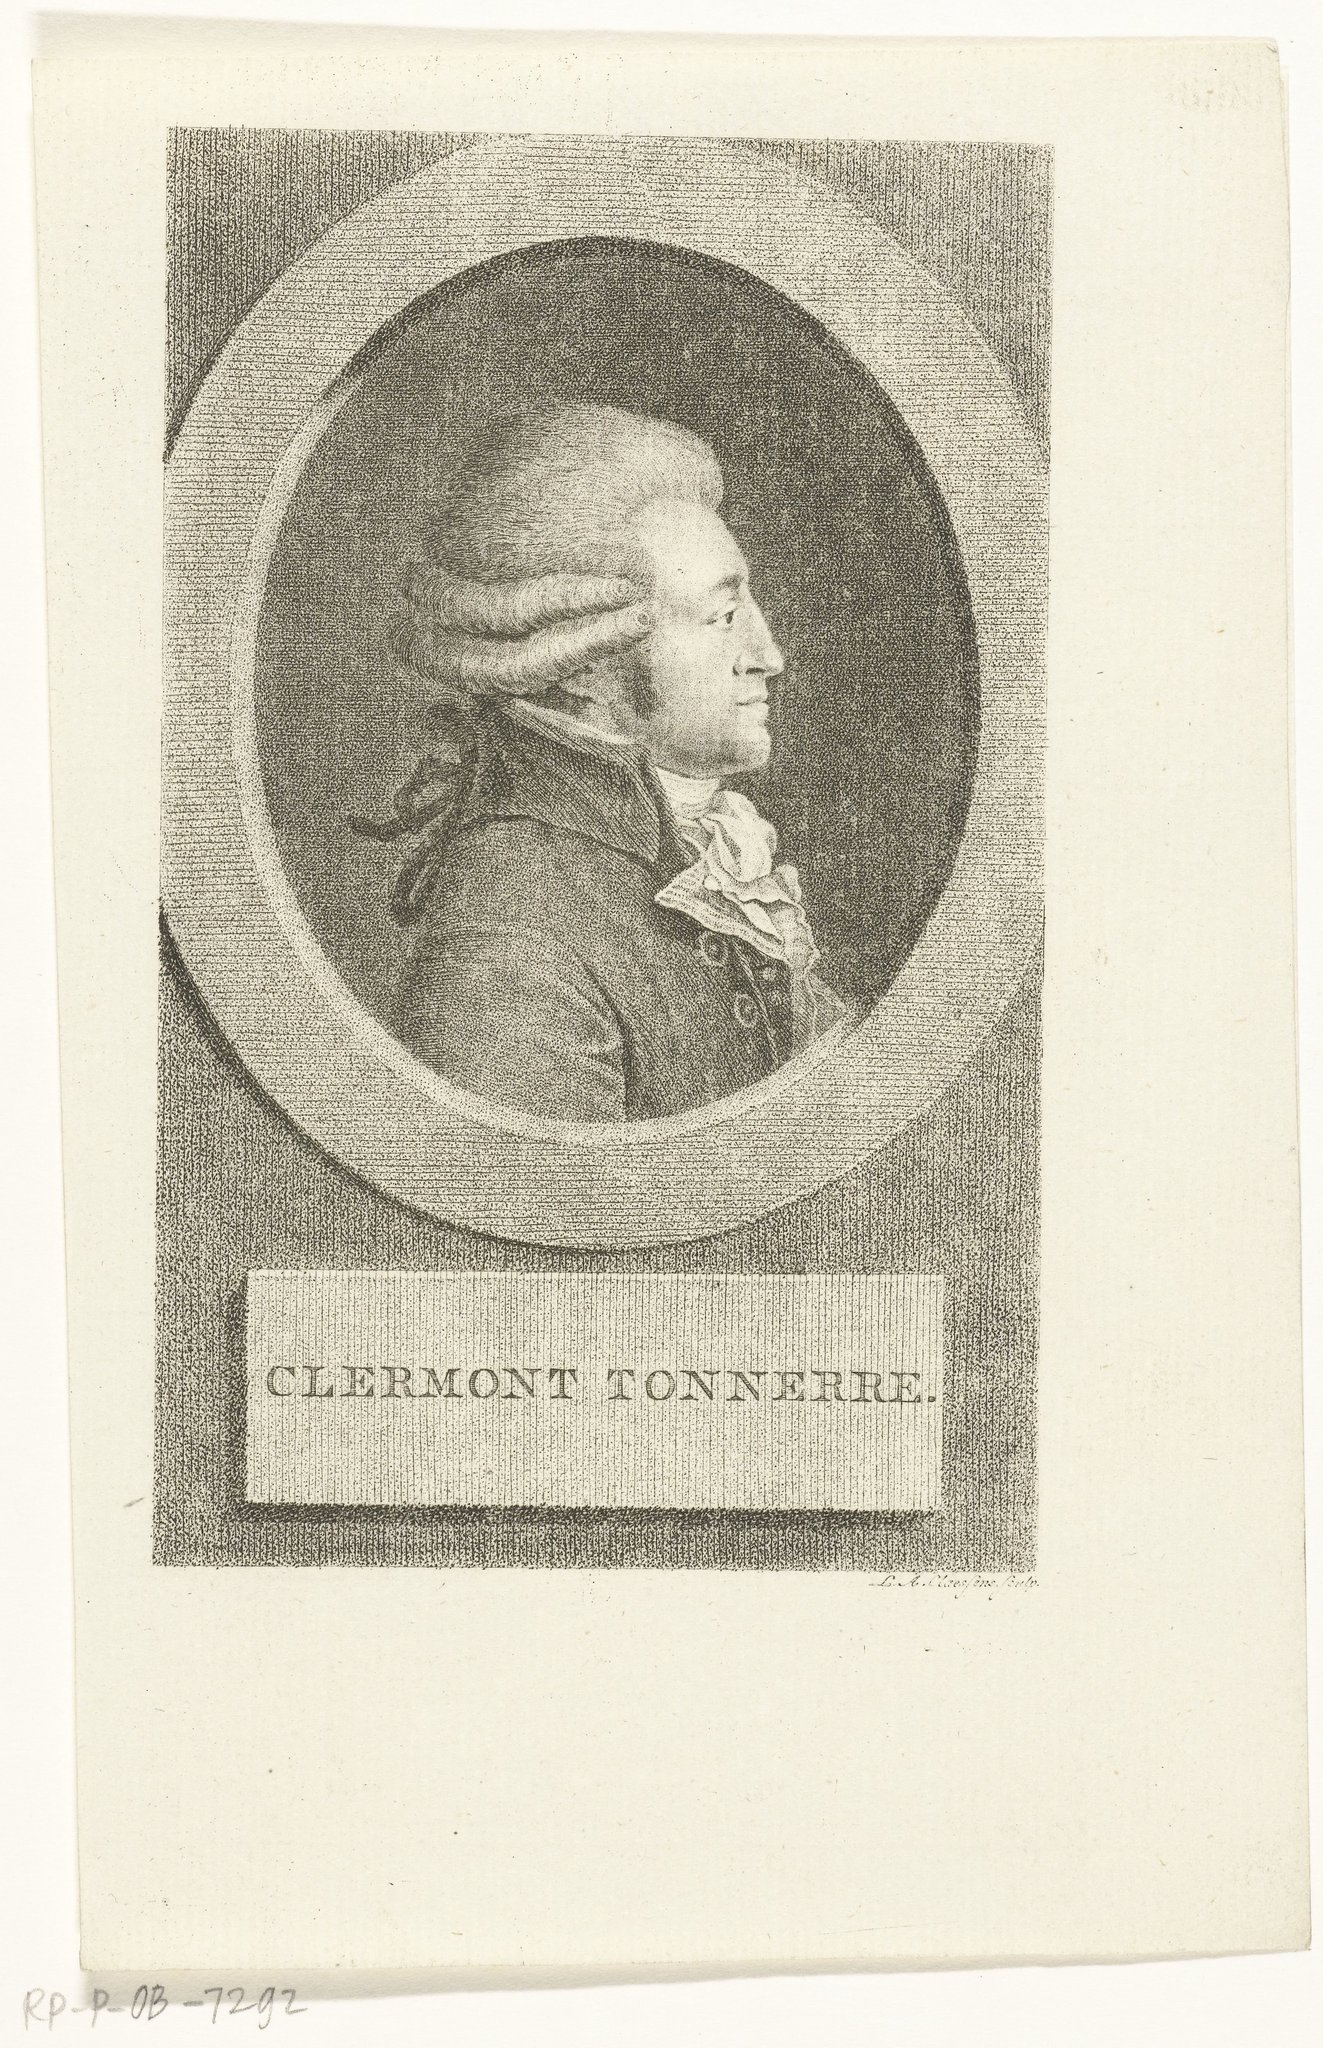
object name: print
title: Portret van Stanislas Marie Adélaïde graaf van Clermont-Tonnerre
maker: lambertus antonius claessens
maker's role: draughtsman, print maker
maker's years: 1763-1834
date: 1792-1808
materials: paper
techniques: engraving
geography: amsterdam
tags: politician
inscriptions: collector's mark: Lugt 2228